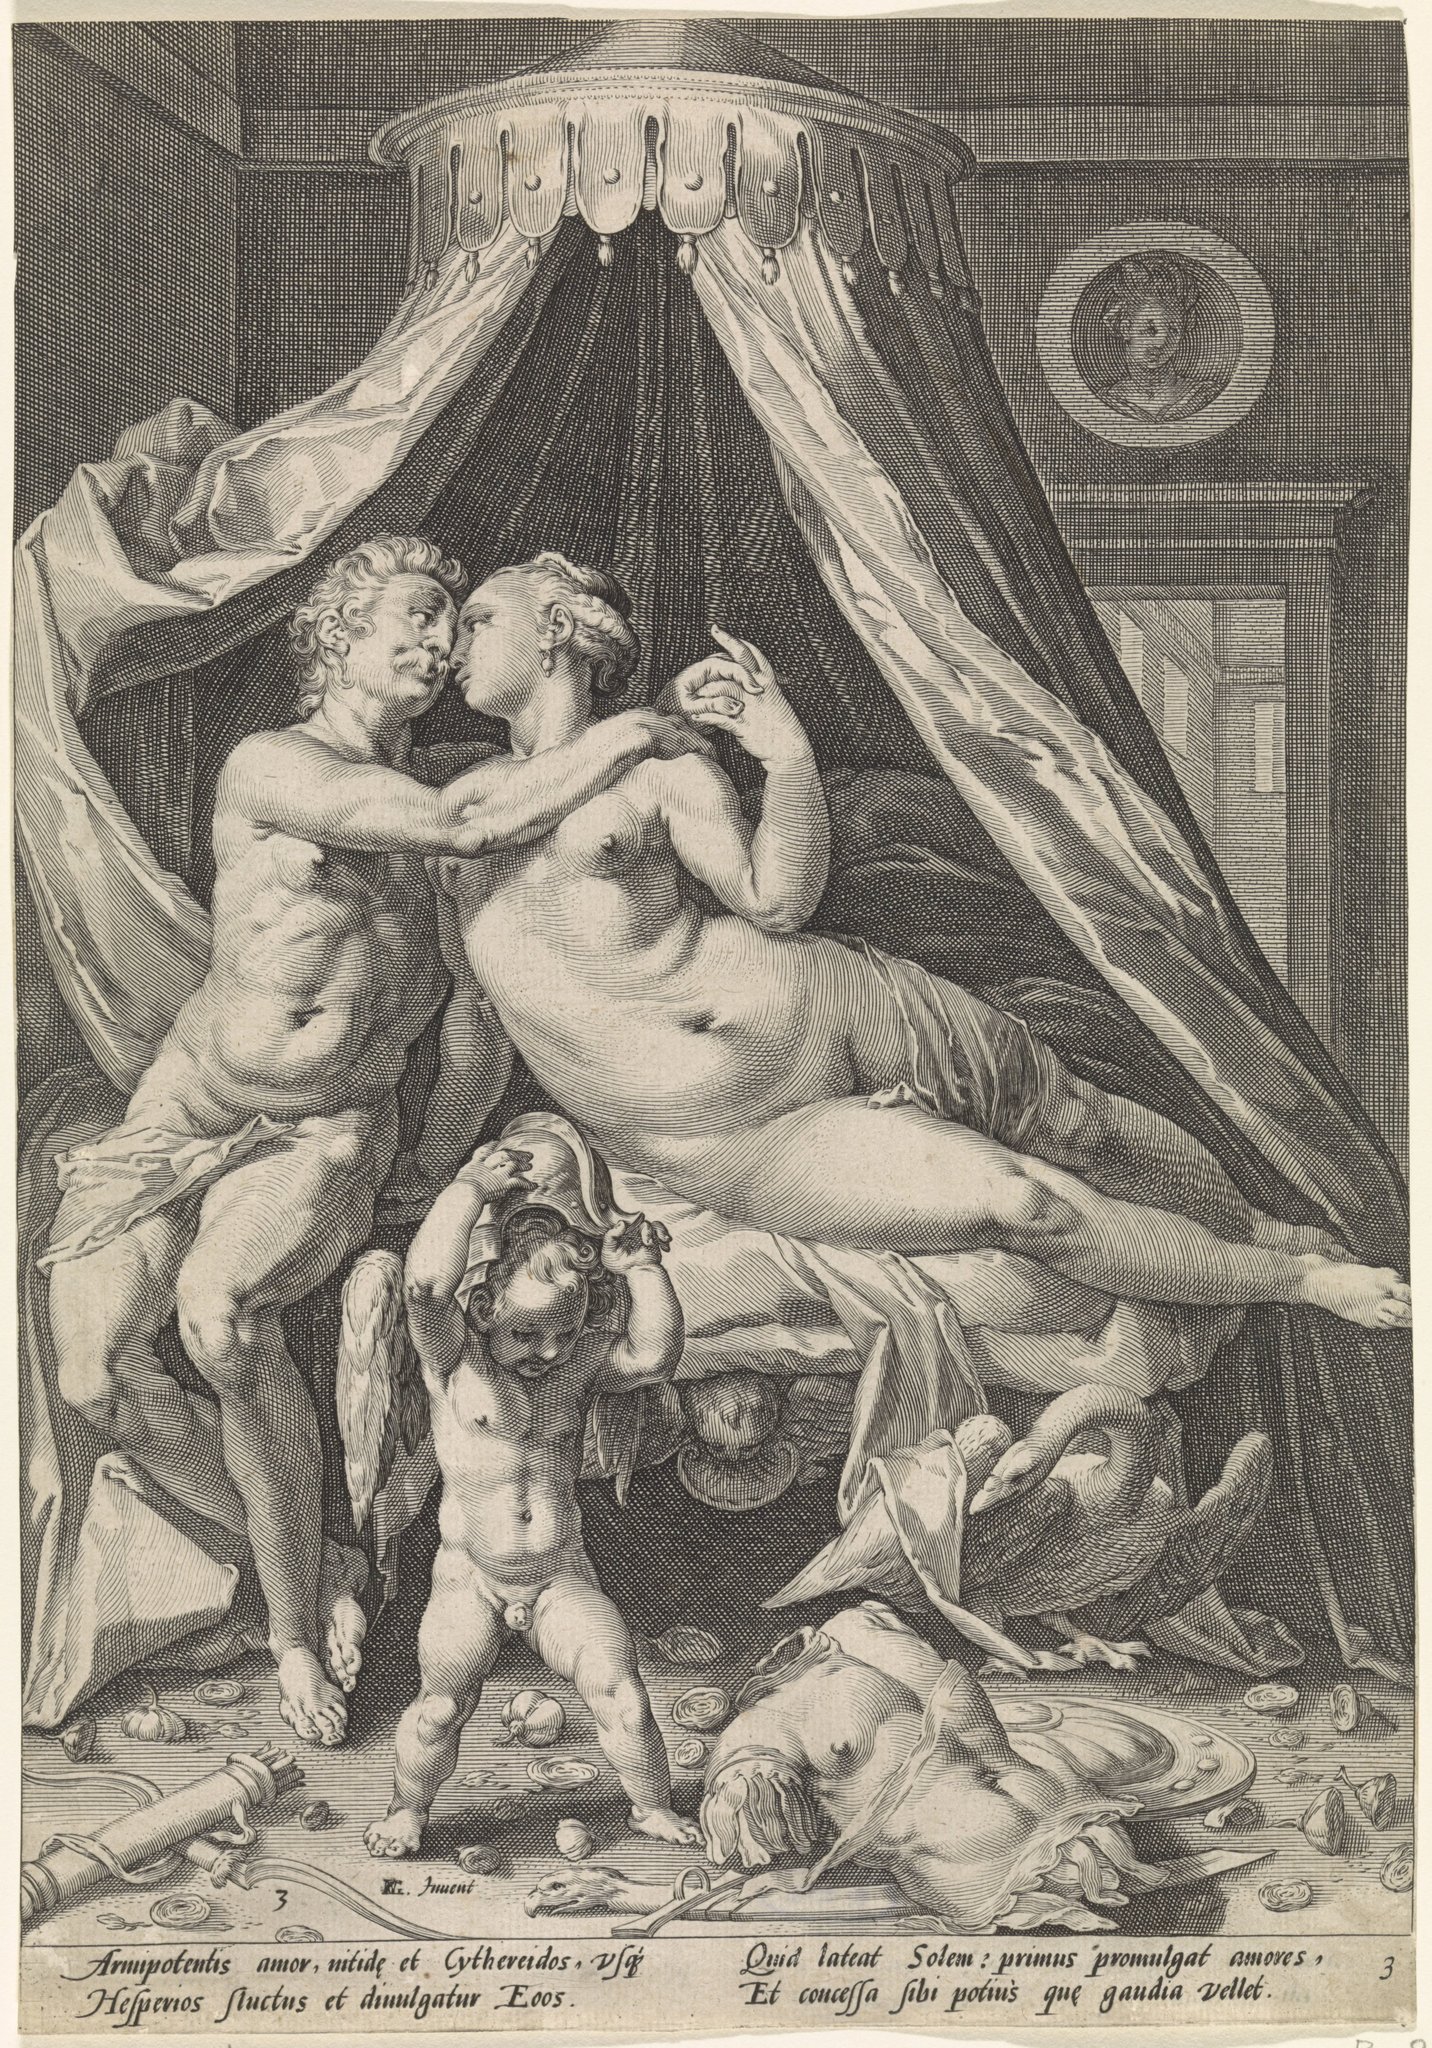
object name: print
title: Mars en Venus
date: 1592-1594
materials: paper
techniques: engraving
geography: haarlem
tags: mars and venus as lovers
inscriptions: collector's mark: Lugt 2228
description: Mars en Venus in een amoureuze omhelzing op een bed. Op de voorgrond speelt Amor met de wapenrusting van Mars.